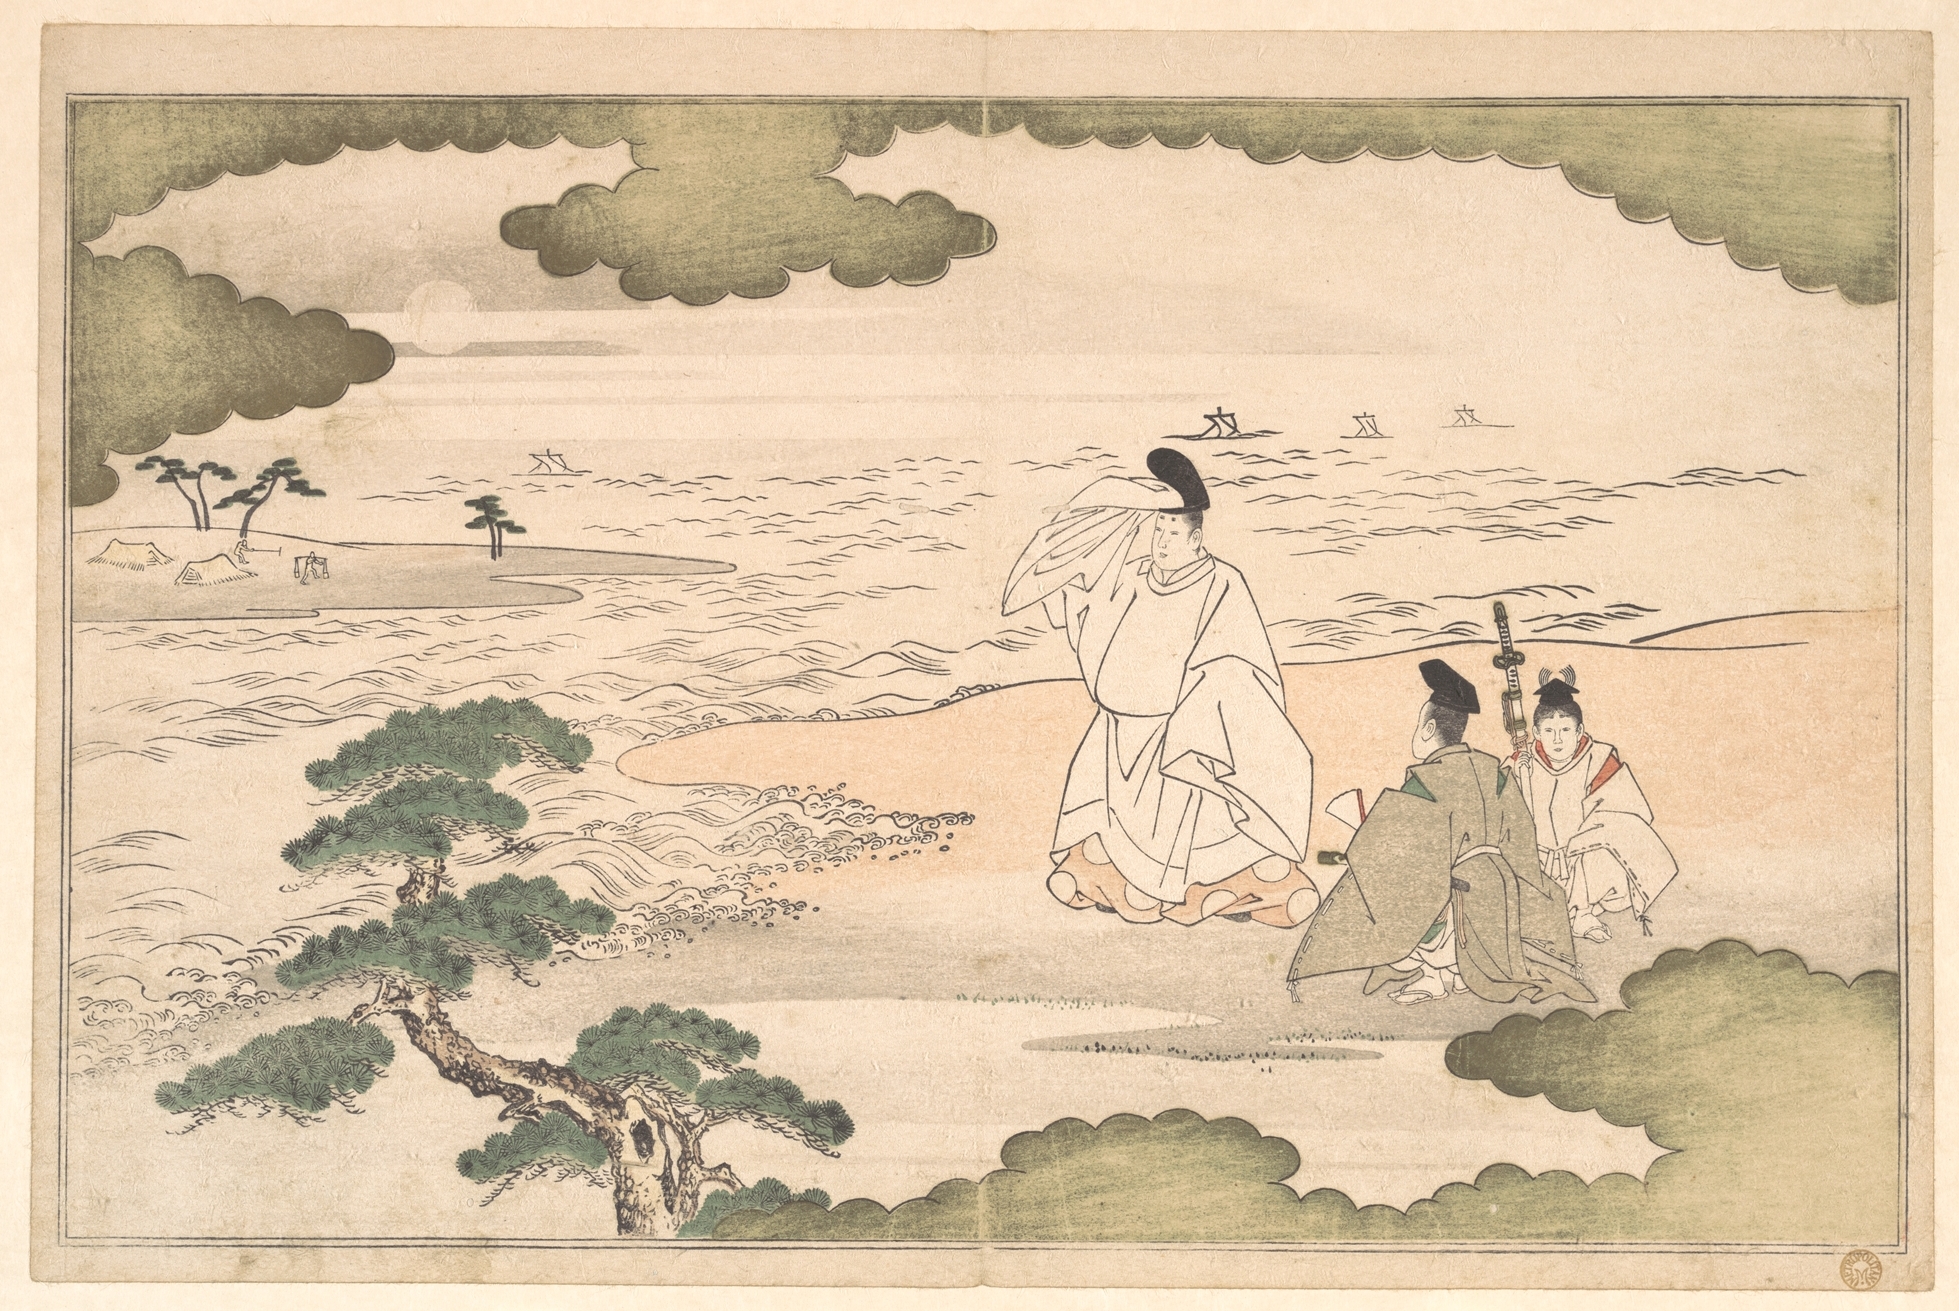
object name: print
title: The Exile of Yukihira at Suma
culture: japanese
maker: kitagawa utamaro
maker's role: artist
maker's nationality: japanese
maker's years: 1754-1806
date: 1789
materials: ink, paper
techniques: woodblock print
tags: men,beaches